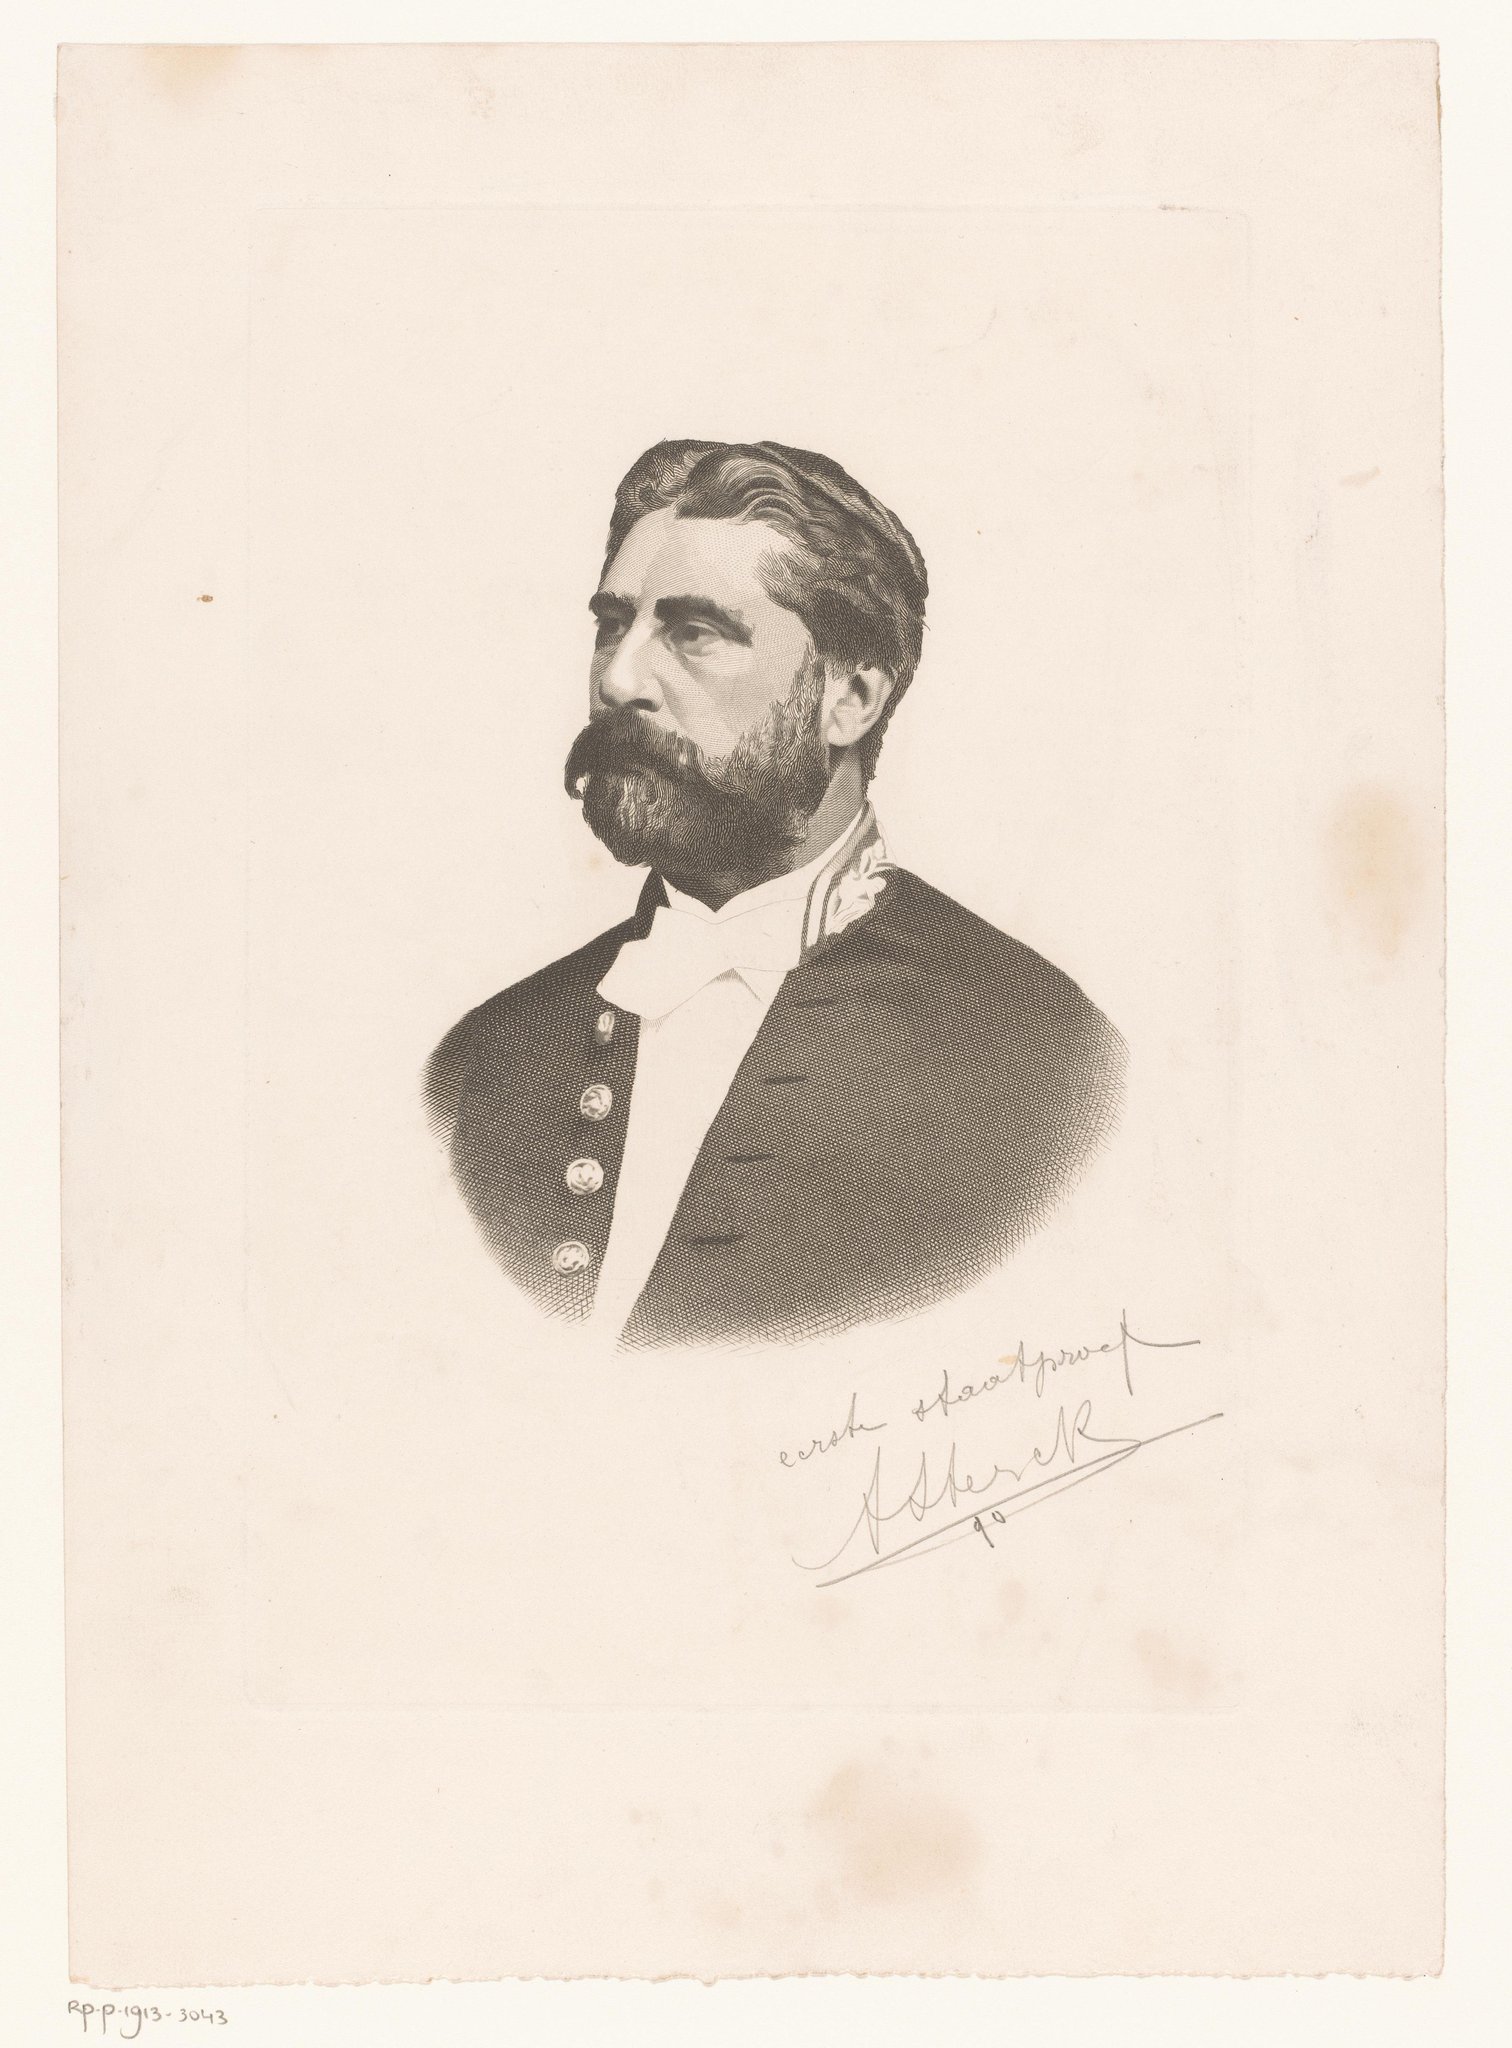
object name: print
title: Portret van André-Casimir Biard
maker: arthur sterck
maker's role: print maker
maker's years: 1868-1897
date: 1890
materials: paper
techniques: engraving, etching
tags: historical persons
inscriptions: collector's mark: Lugt 2228, annotation: ‘Eerste staat proef’